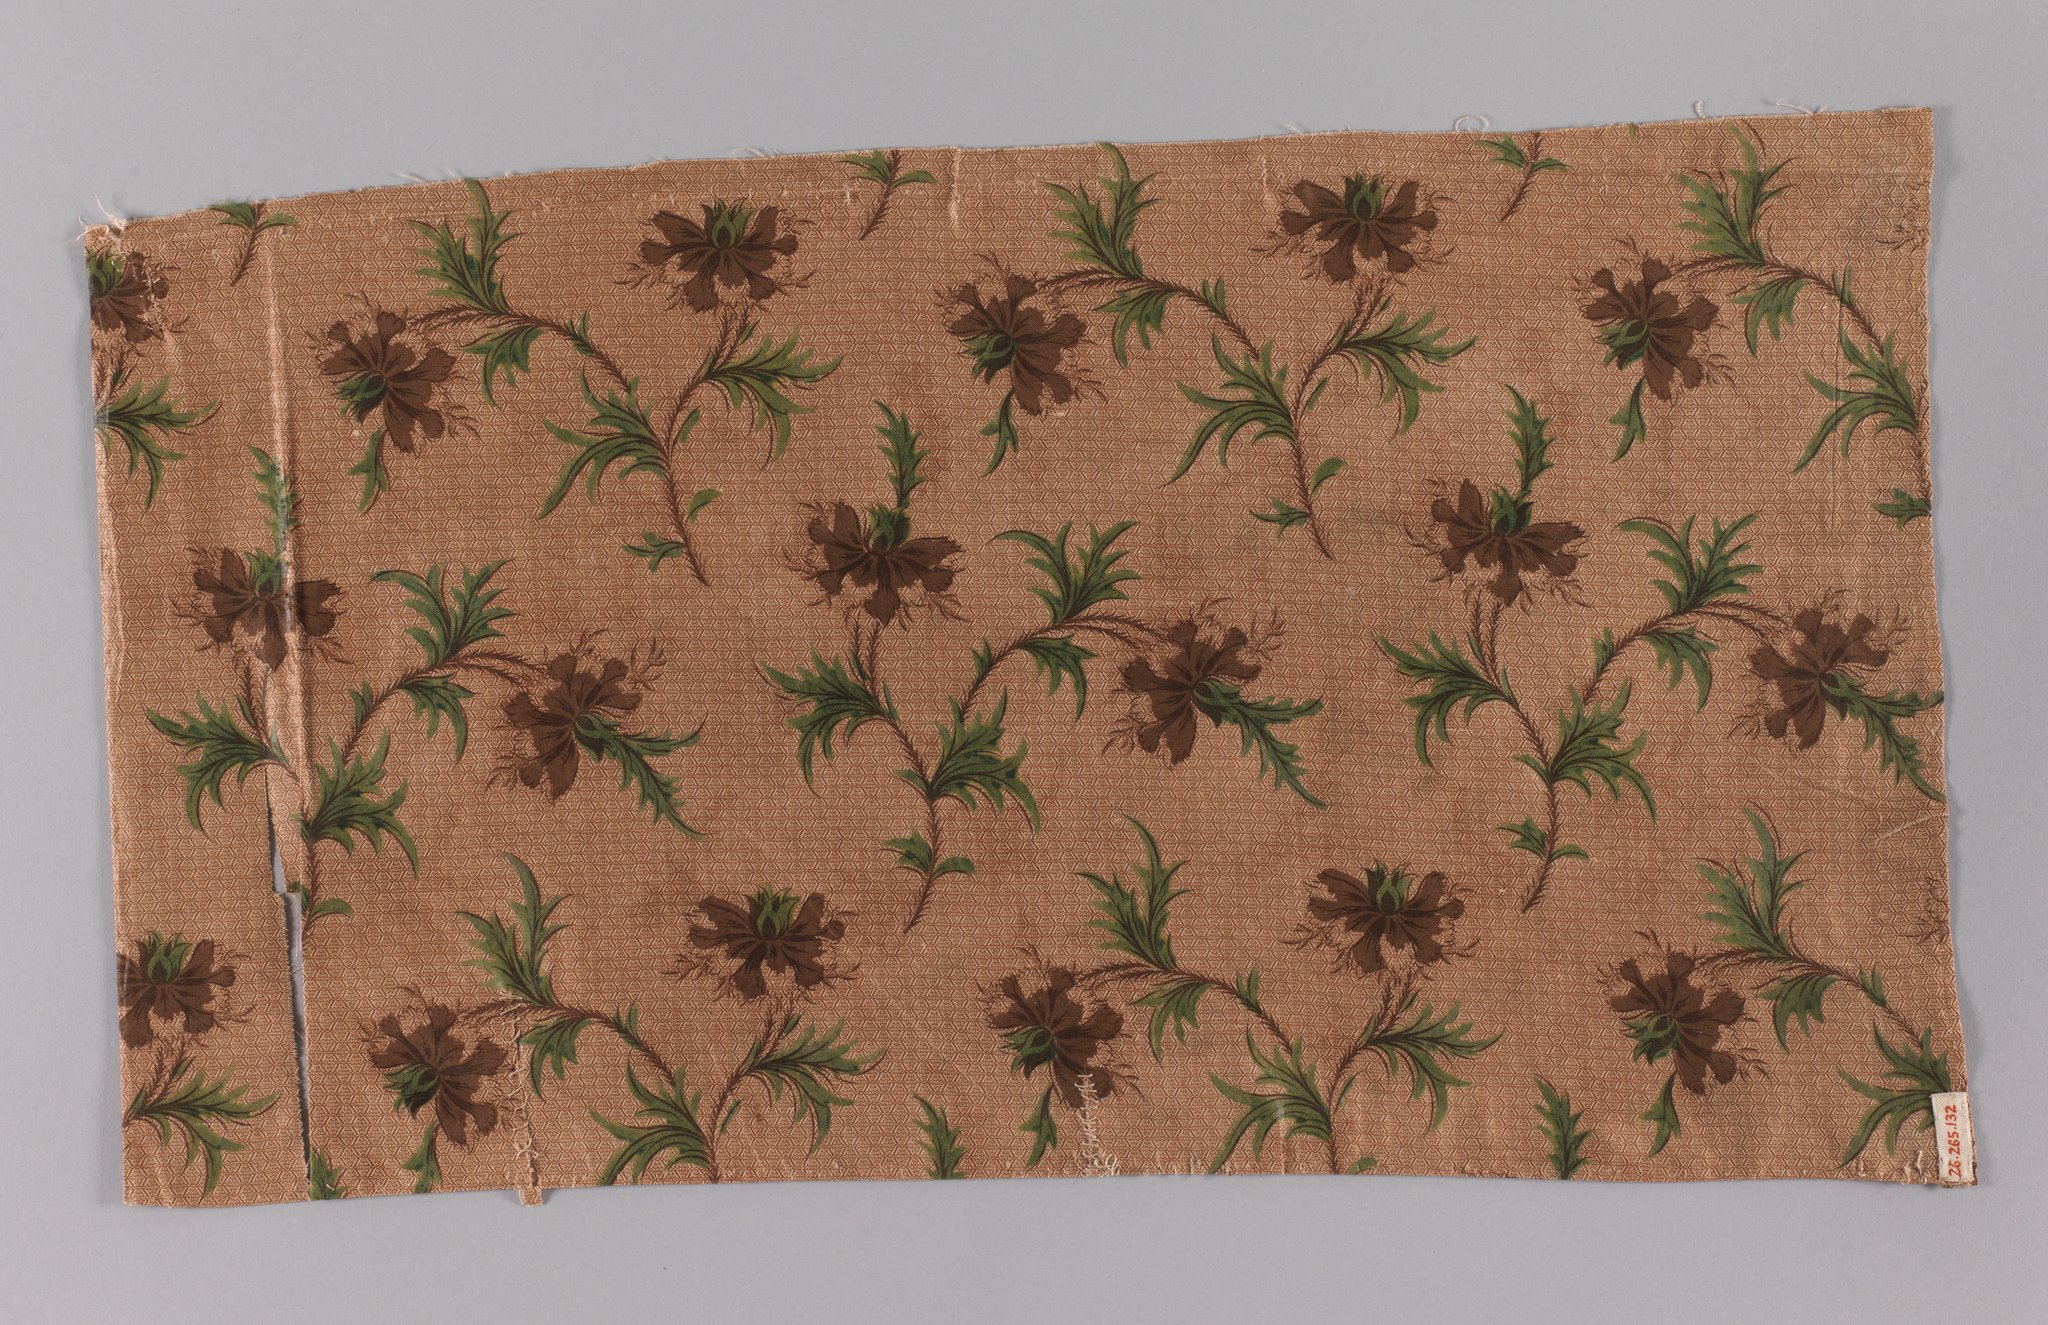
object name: piece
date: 1840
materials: cotton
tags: flowers